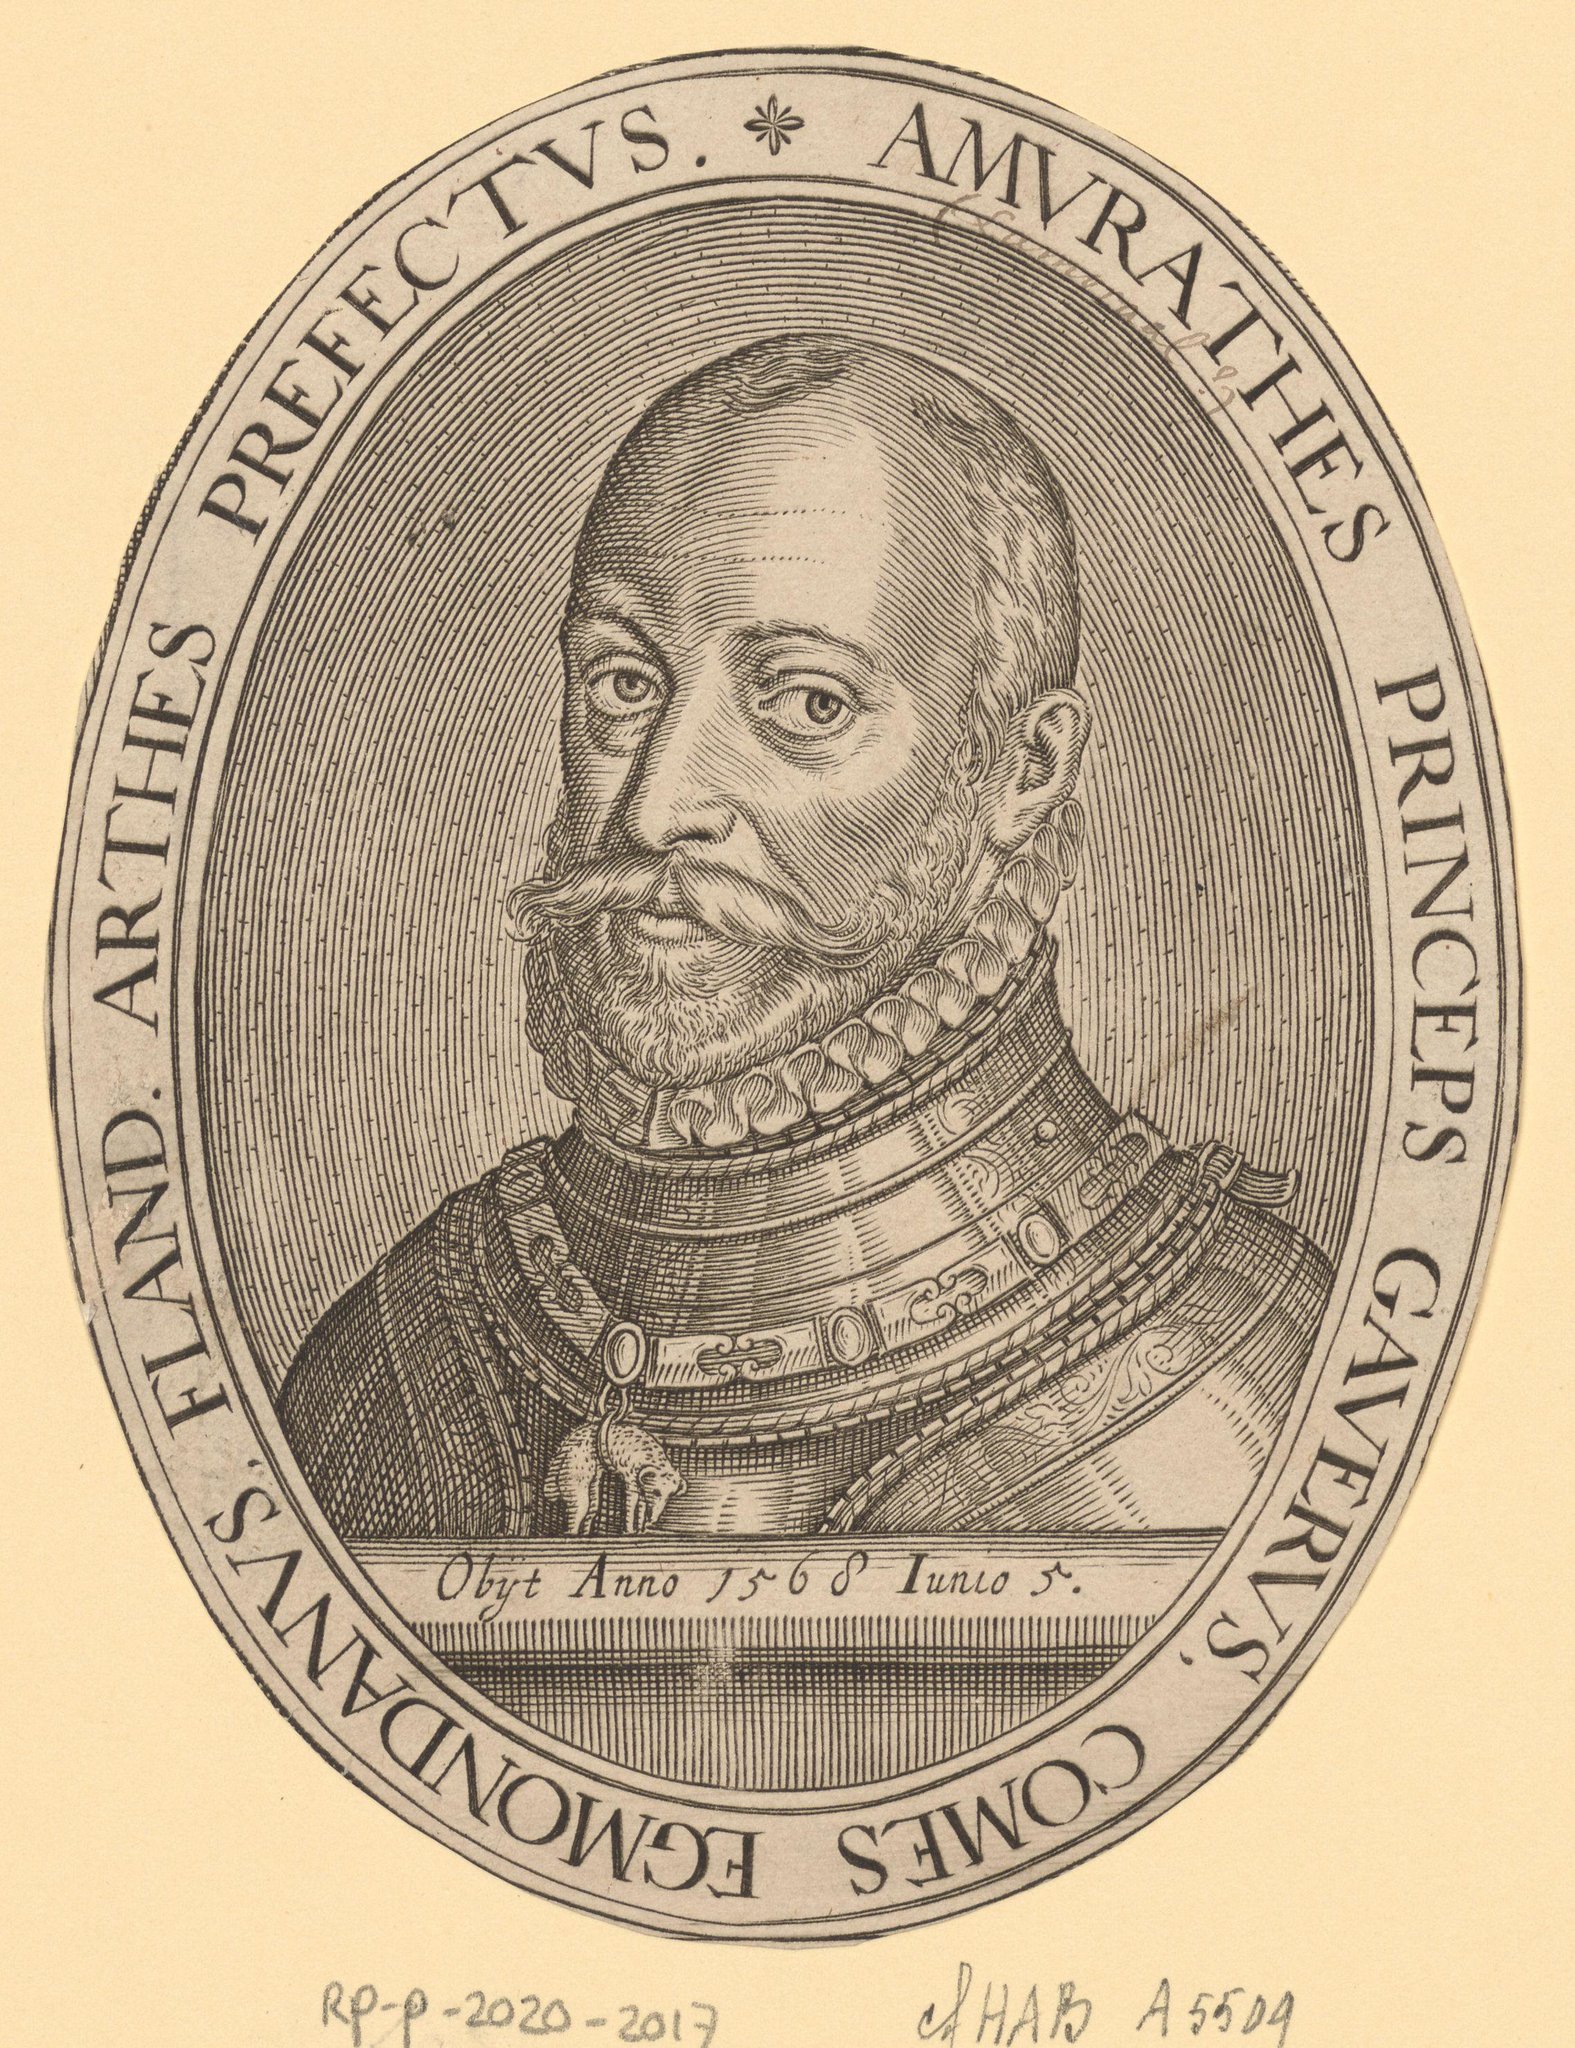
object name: print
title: Portret van Lamoraal van Egmond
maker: Anonymous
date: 1614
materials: paper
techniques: engraving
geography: northern netherlands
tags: earl, historical persons, knighthood order of the golden fleece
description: Prent met tekst op verso gebruikt in: Meteren, Emanuel van. Historie der Neder-landscher ende haerder na-buren oorlogen (...). Den Haag: Hillebrant Jacobsz van Wouw, 1614, p. 58. Prent mogelijk ook gebruikt in eerdere of latere edities.